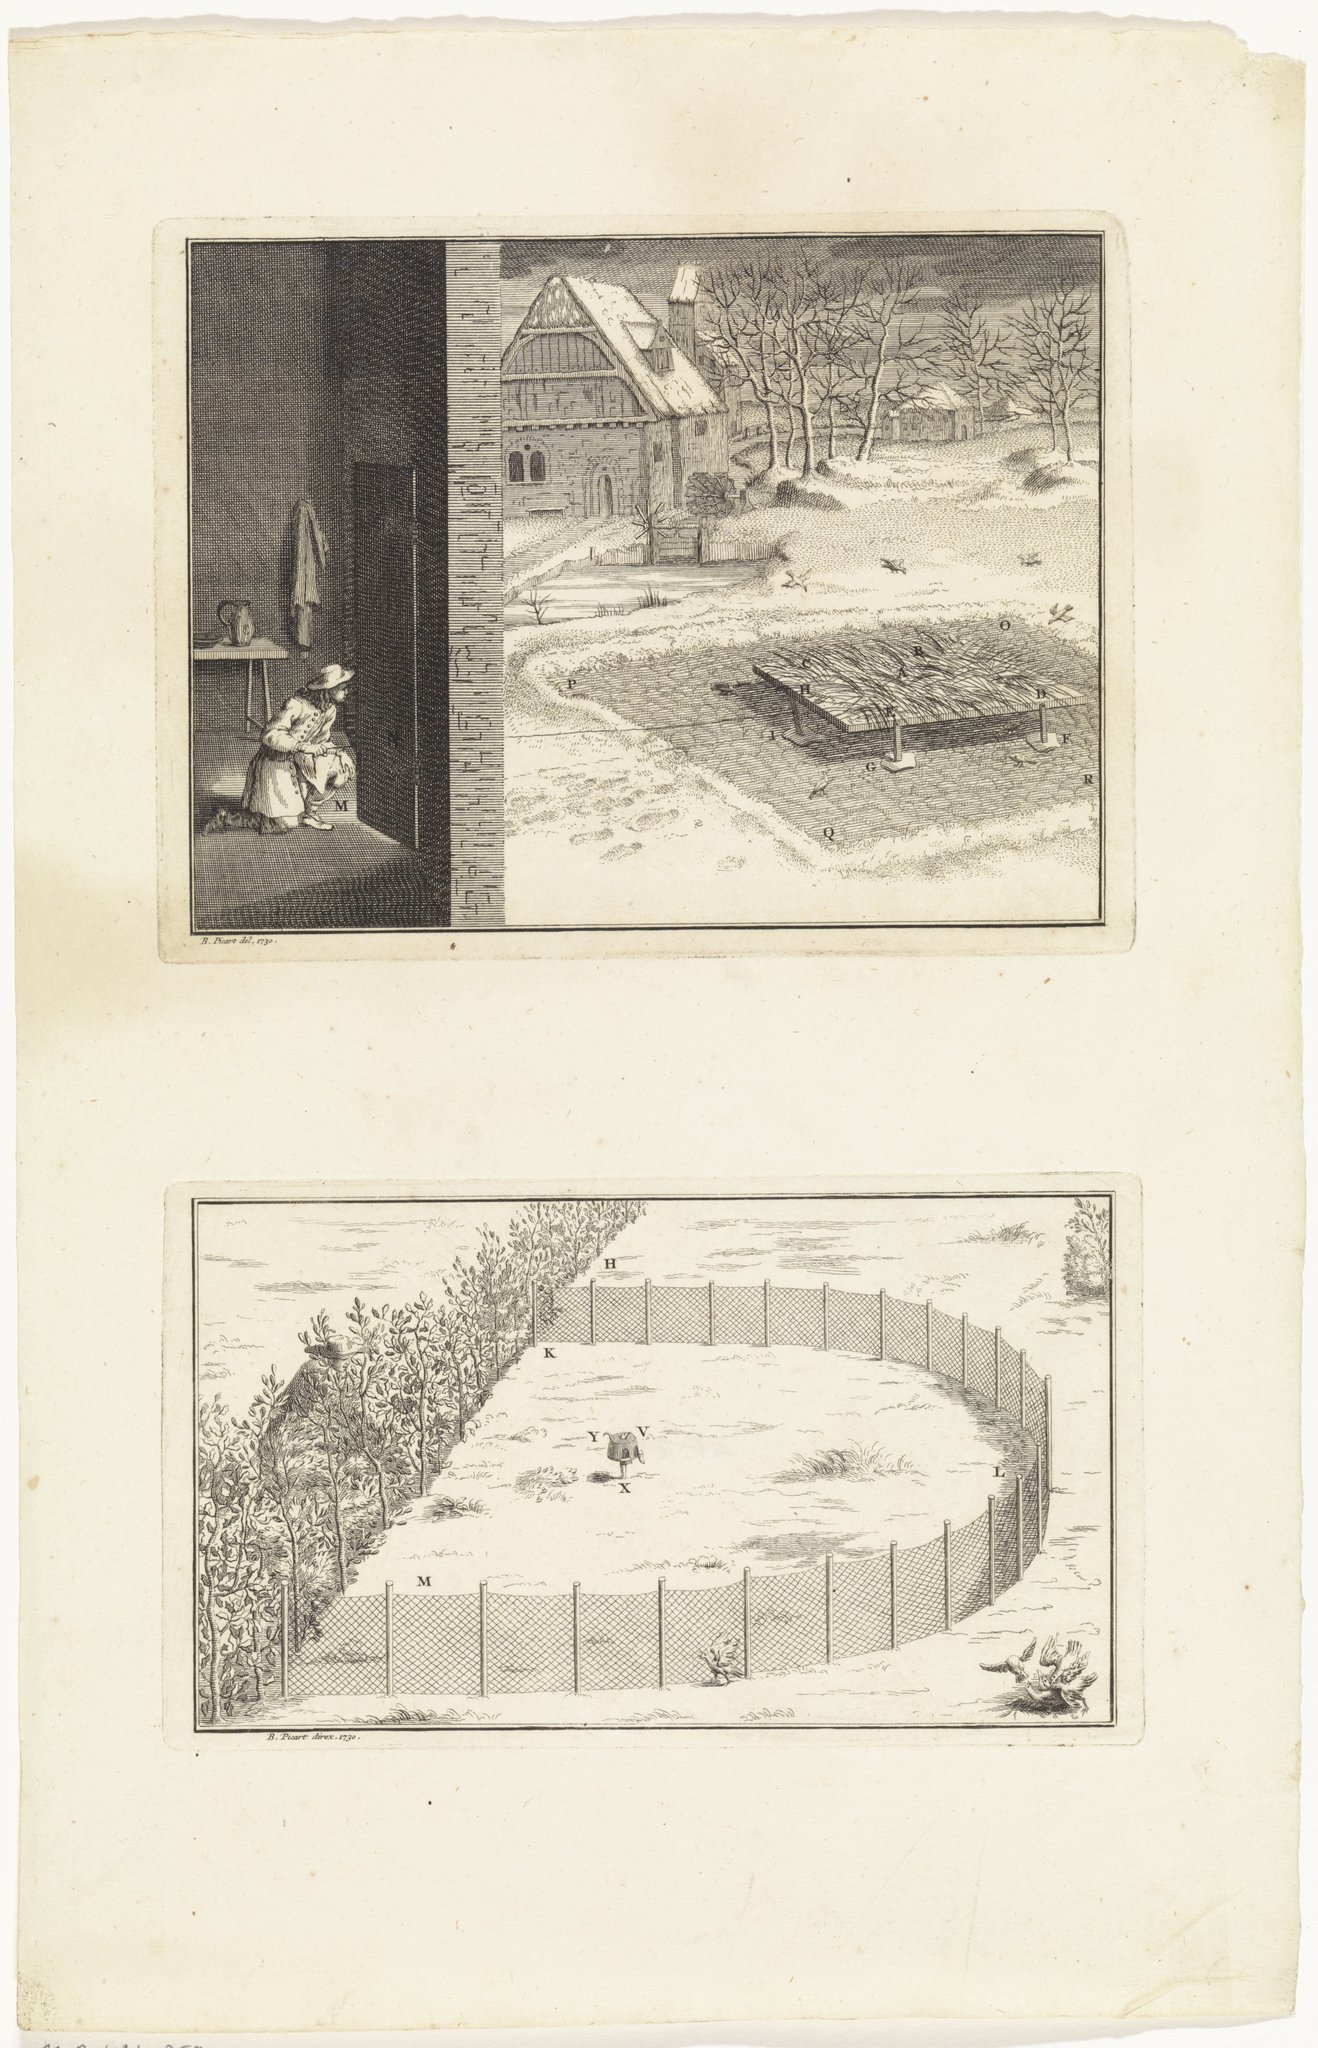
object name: print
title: Twee constructies om vogels te vangen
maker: bernard picart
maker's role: draughtsman, print maker, publisher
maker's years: 1673-1733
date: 1730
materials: paper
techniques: etching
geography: amsterdam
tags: bird hunting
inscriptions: collector's mark: Lugt 2233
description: Twee voorstellingen op een blad. Boven: Winterlandschap met een man, die vogels vangt. Hij zit binnen en zal aan het touw trekken, zodra er vogels onder zijn val zitten. Onder: Een man wacht tussen de struiken tot er vogels in zijn lokhuisje vliegen.